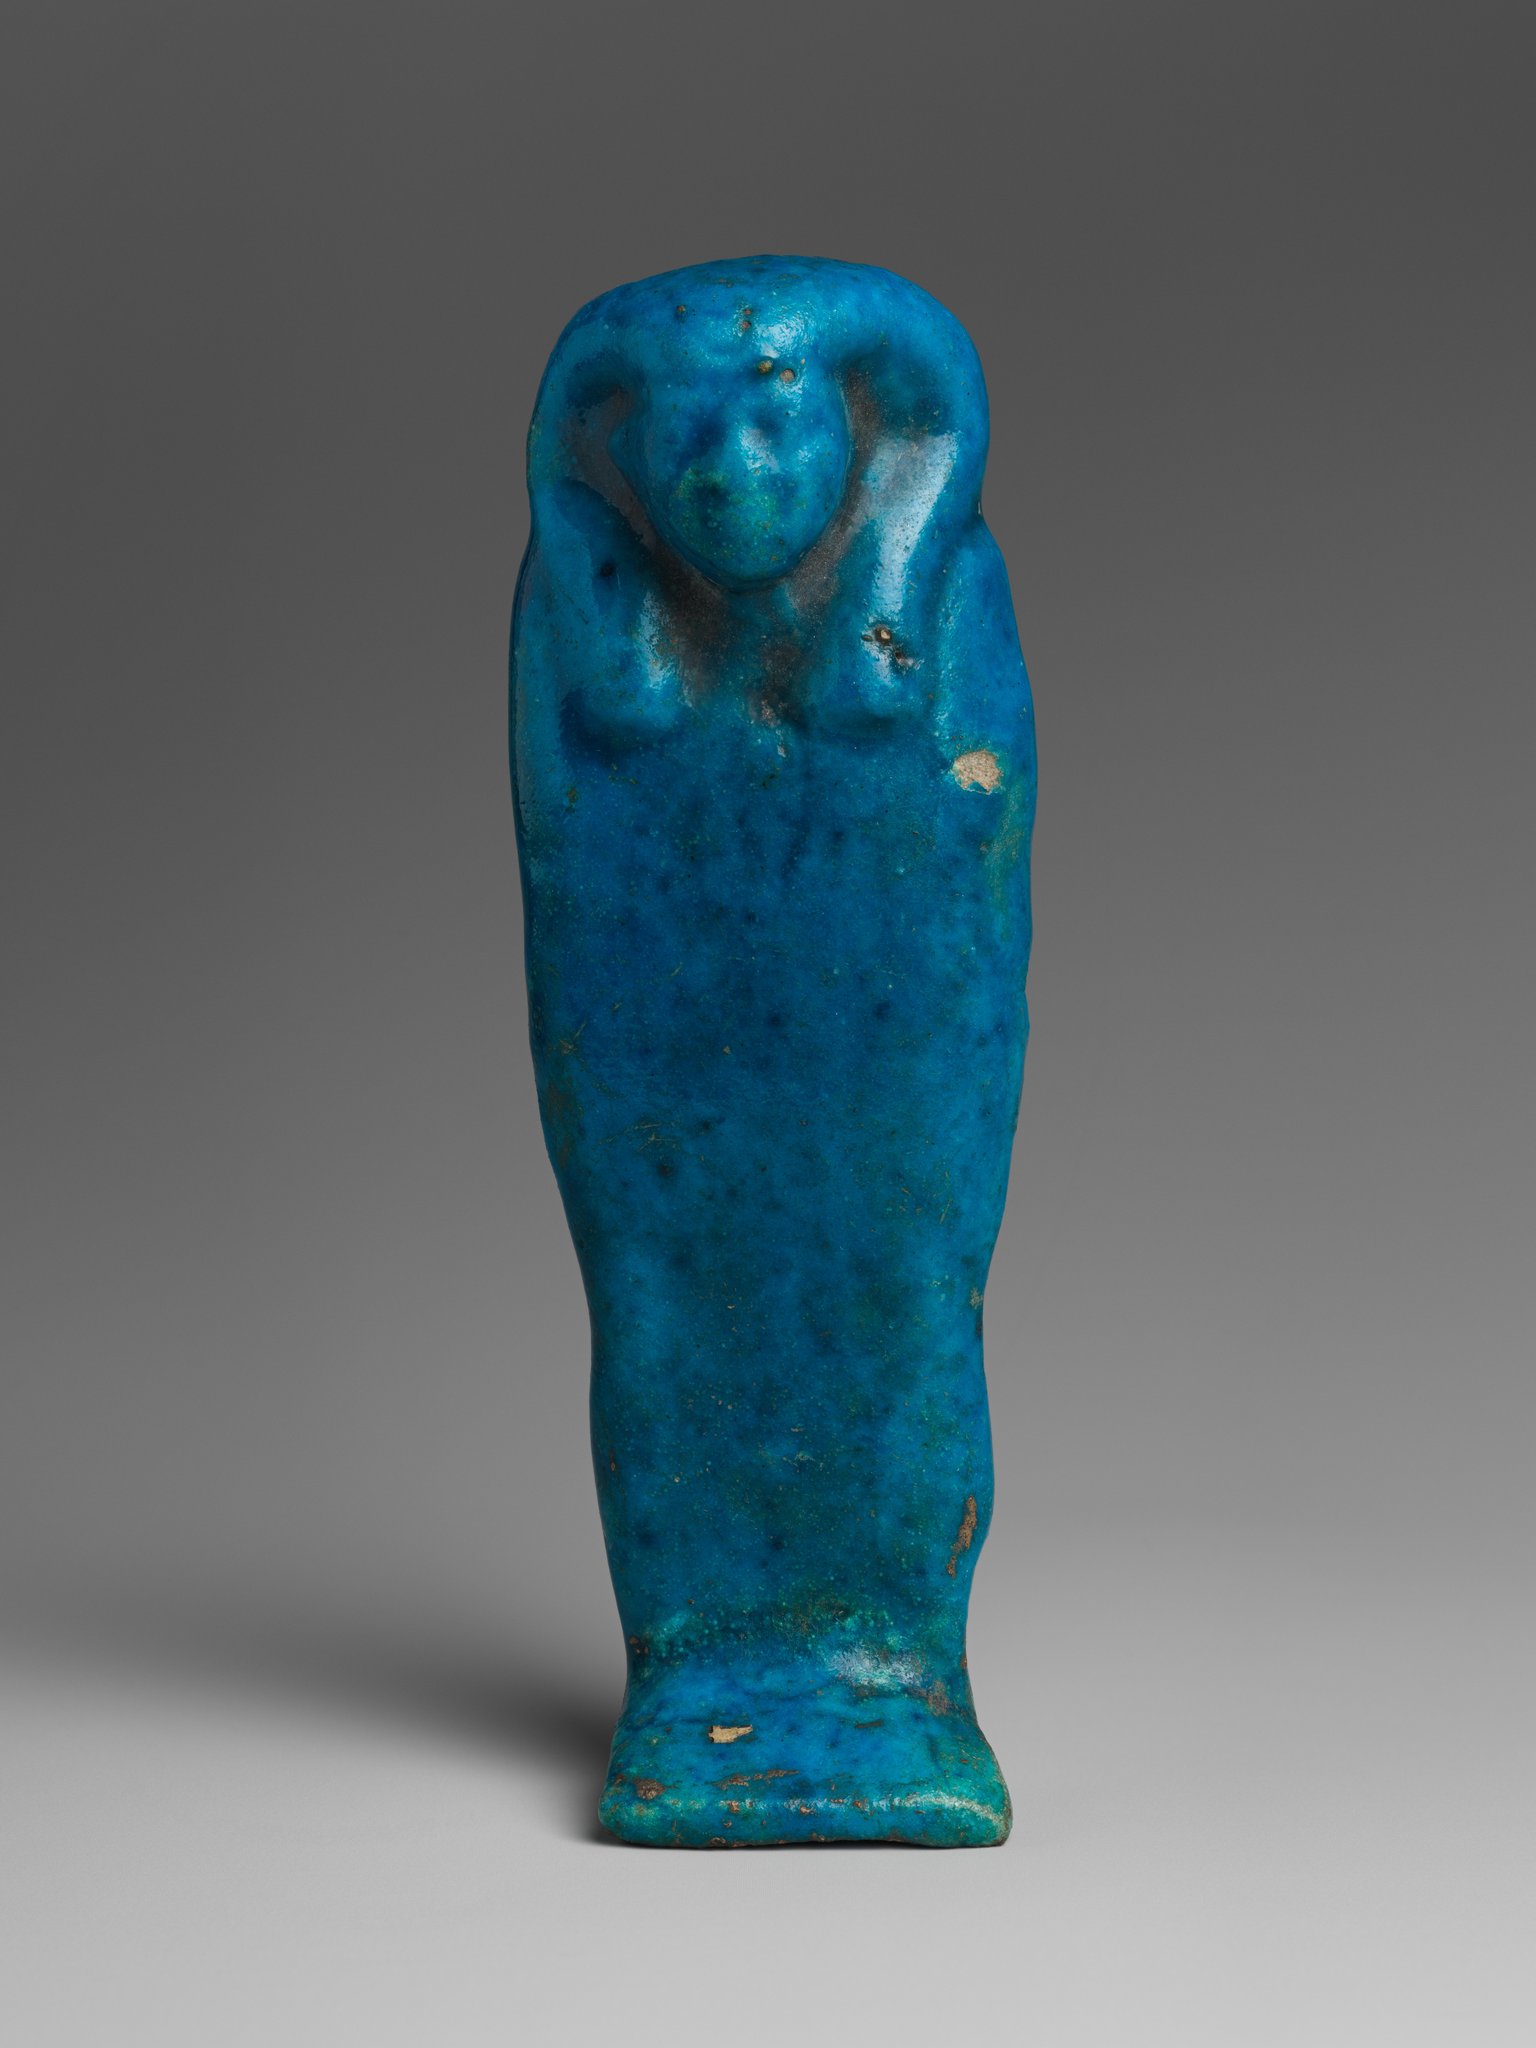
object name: shabti, uninscribed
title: Uninscribed shabti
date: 1070-720 BCE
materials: faience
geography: egypt